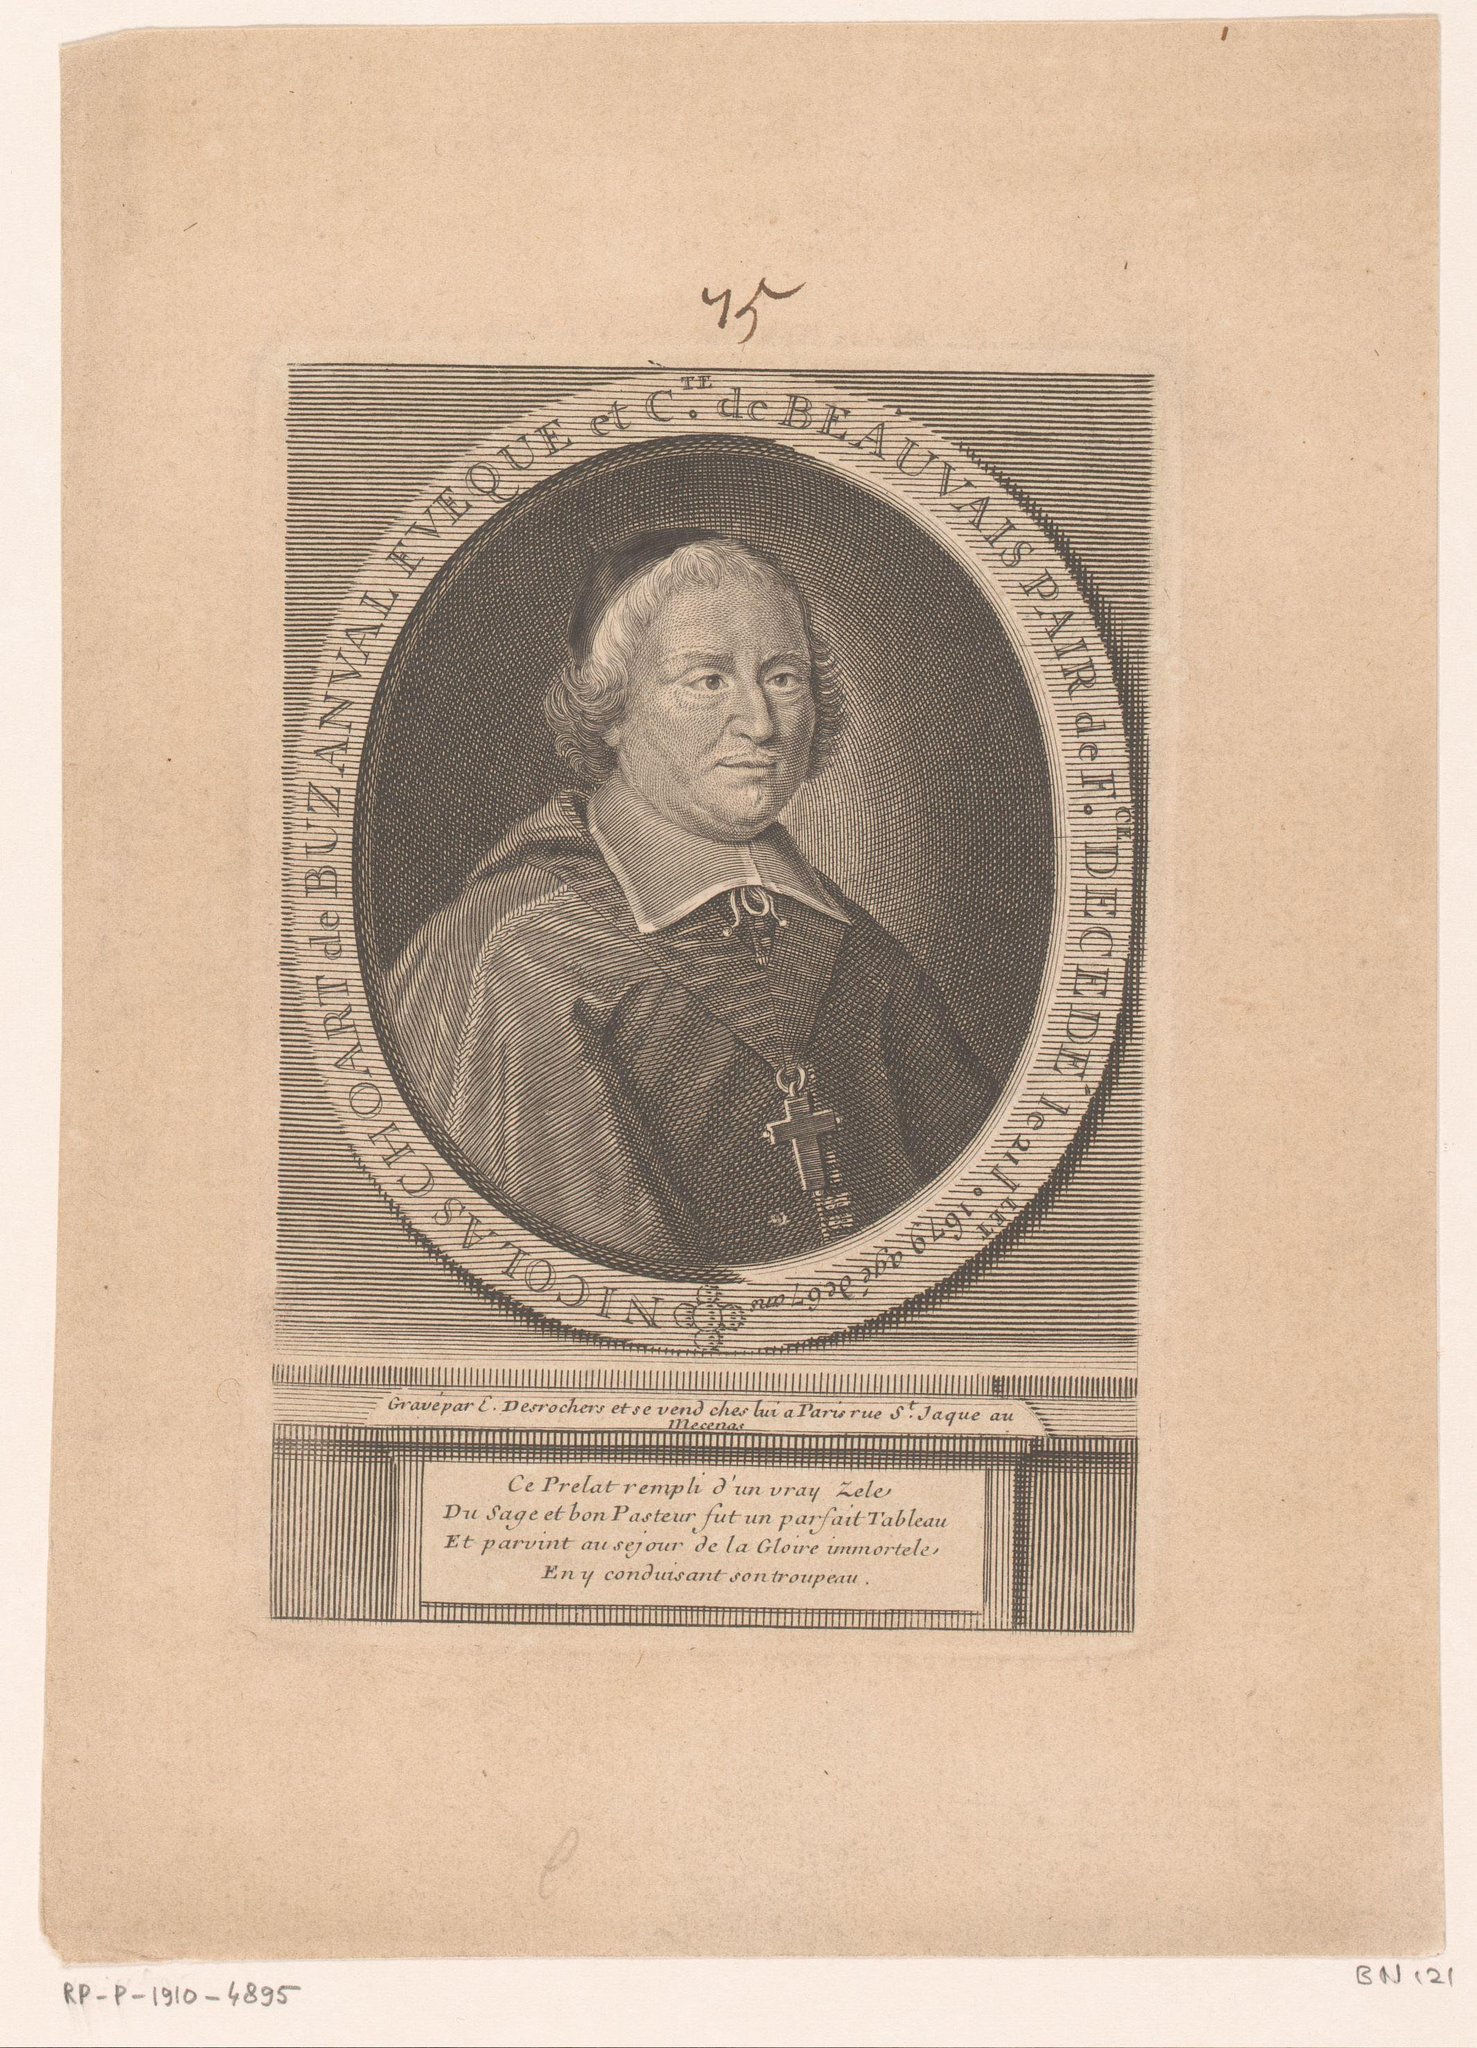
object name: print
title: Portret van Nicolas Choart de Buzenval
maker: étienne desrochers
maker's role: print maker, publisher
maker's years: 1668-1741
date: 1726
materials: paper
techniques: engraving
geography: paris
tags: paris, archbishop, bishop, etc. (roman catholic), historical persons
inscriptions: number: ‘15’, collector's mark: Lugt 2228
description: Behoort waarschijnlijk tot een serie portretten, grotendeels door Etienne Desrochers, getiteld: 'Recueil de portraits de personnes qui se sont distinguées tant dans les Armes que dans Belles-Lettres et les Arts, comme aussi la famille royale de France et autres cours étrangères'. De serie werd initieel uitgegeven door Desrochers en aangekondigd in 'Mercure' in mei 1726, p. 985. Echter was Desrochers reeds enkele jaren eerder begonnen met het uitgeven van de serie. Na de dood van Desrochers werd de serie voortgezet door Gilles Edme Petit. Een latere staat werd uitgegeven door Jean François Daumont in Parijs.